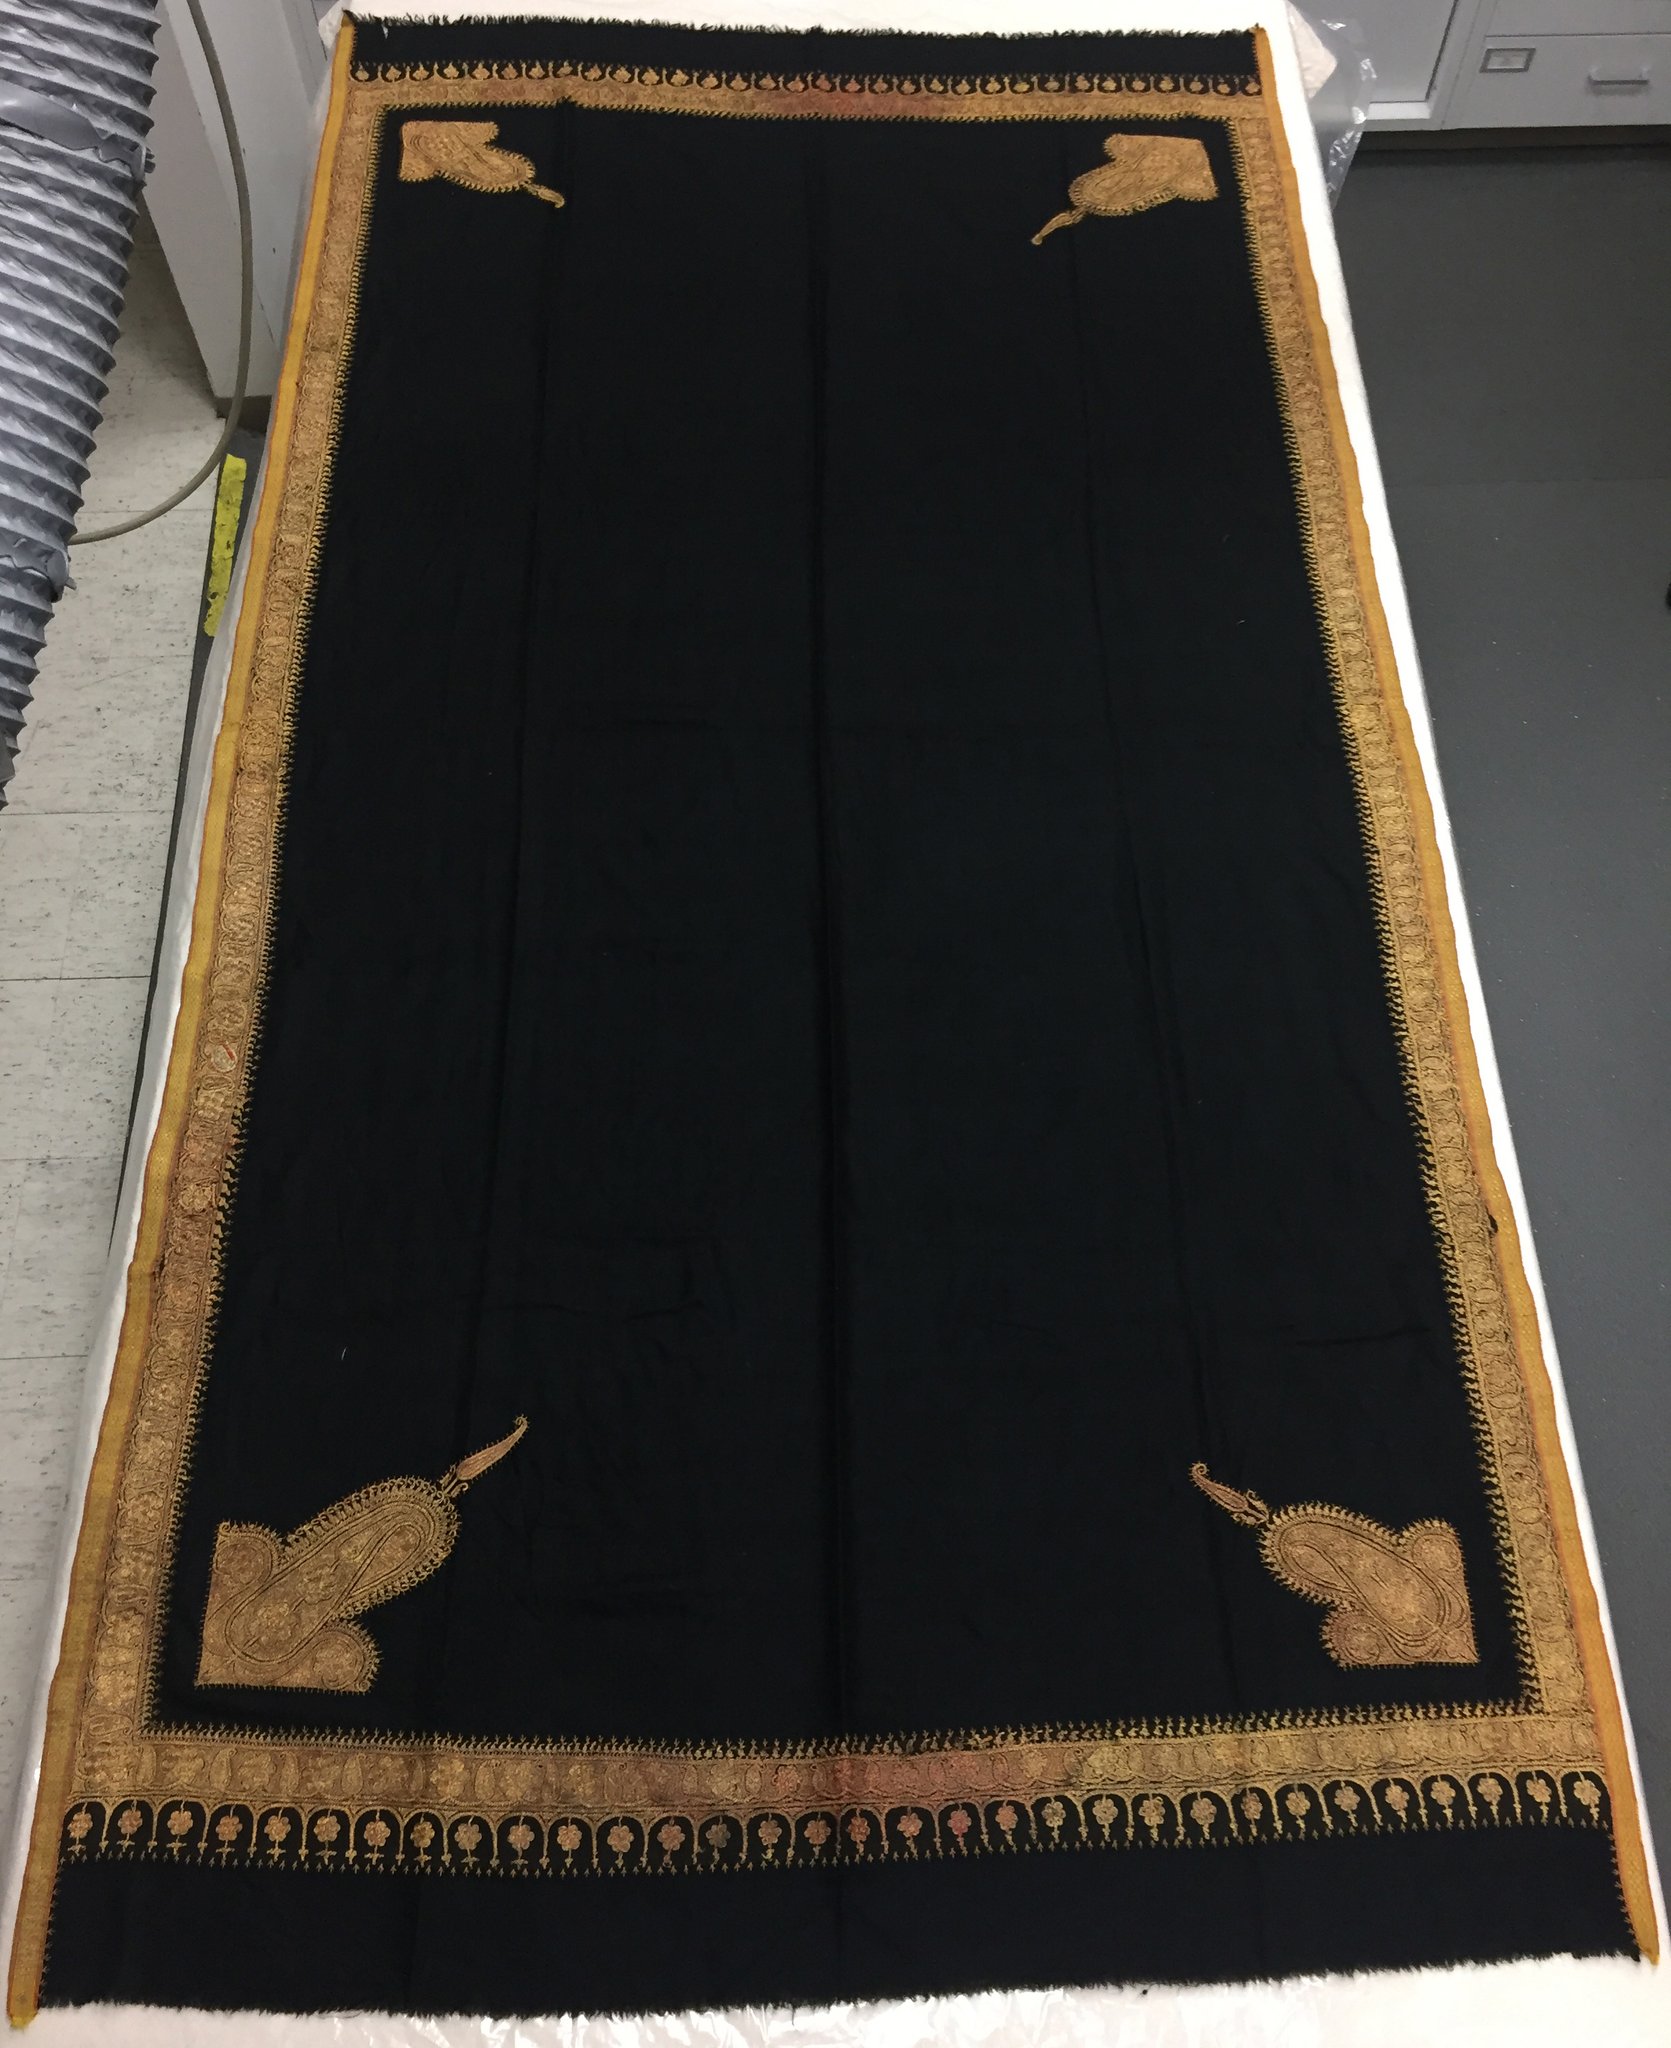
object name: shawl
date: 1801-1900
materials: metal thread, wool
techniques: embroidery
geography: india